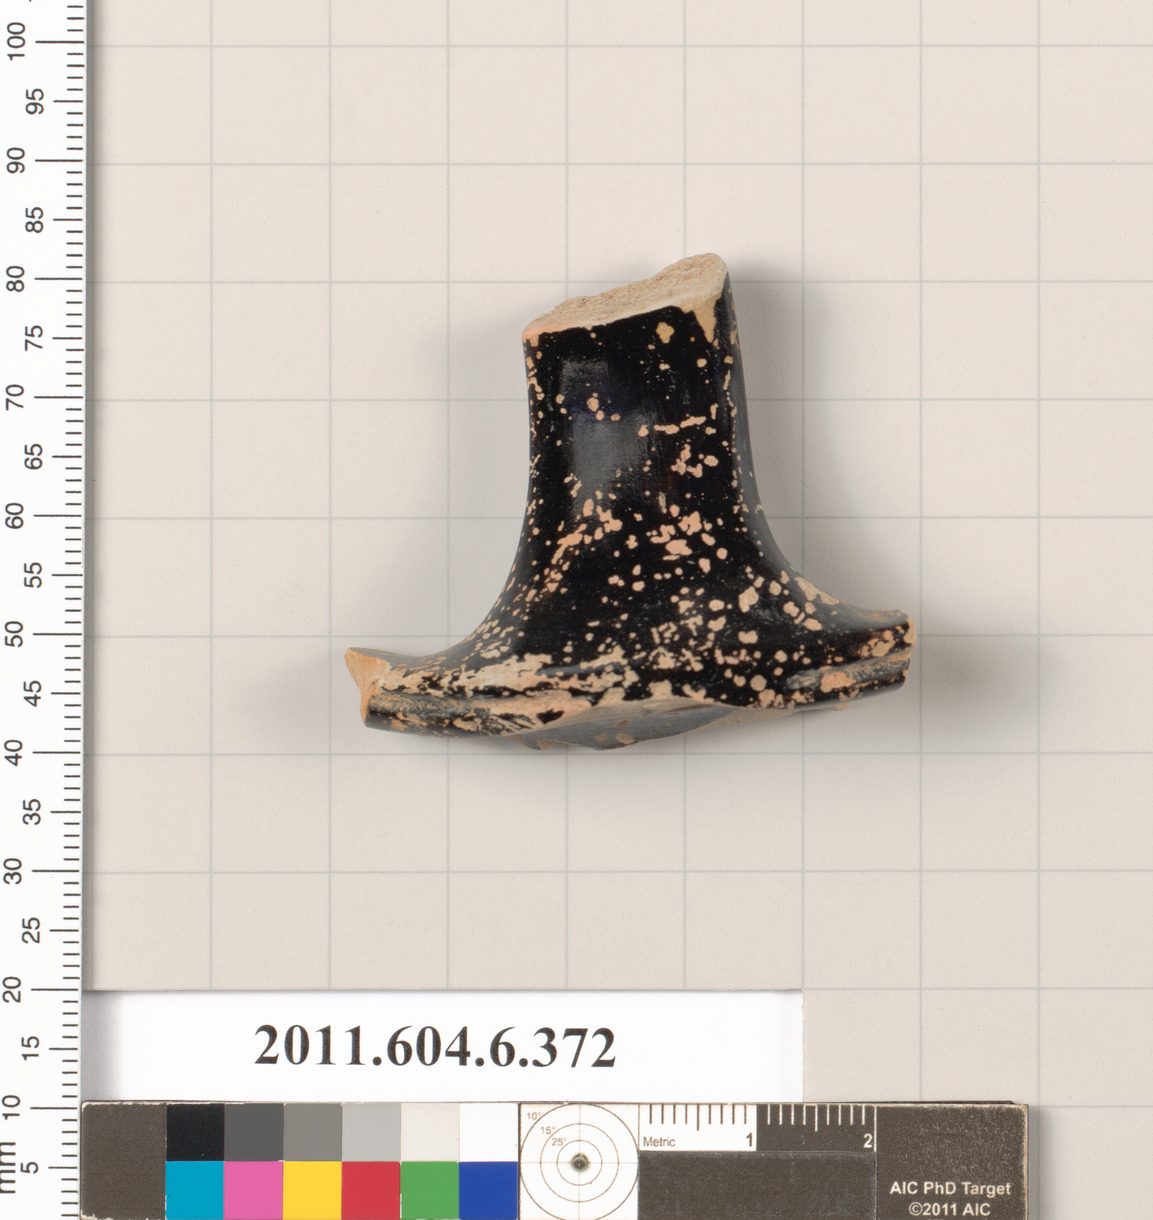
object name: undetermined shape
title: Terracotta fragment of an undetermined shape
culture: greek, attic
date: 600-401 BCE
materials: terracotta